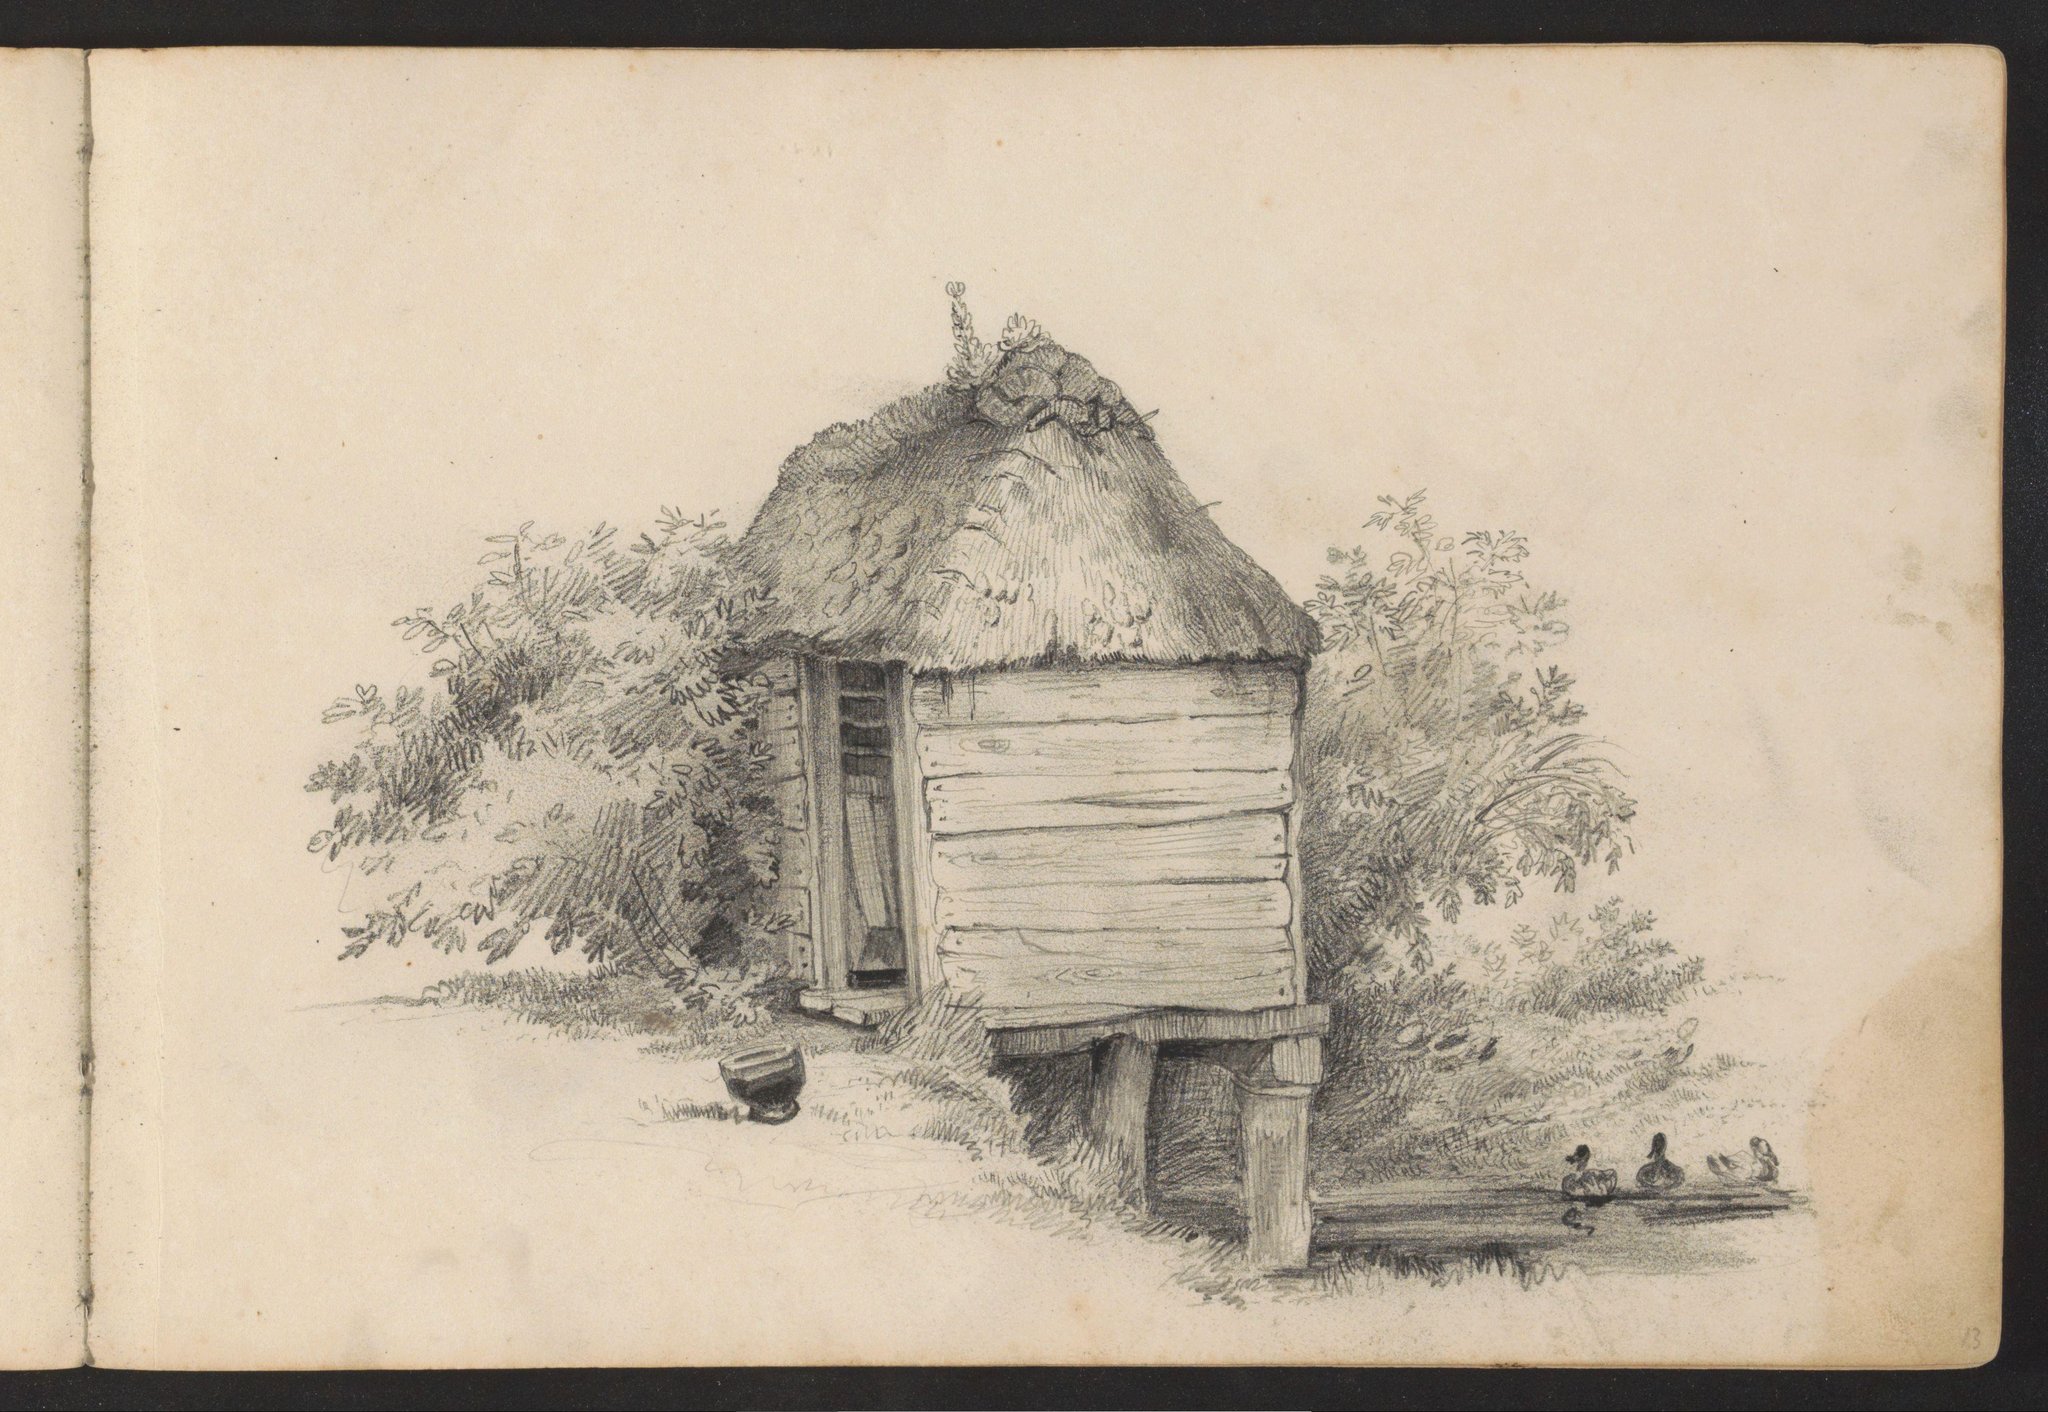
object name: sketchbook leaf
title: Hut op palen aan de waterkant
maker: johannes tavenraat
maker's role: draughtsman, painter, print maker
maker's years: 1809-1881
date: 1842-1868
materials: paper, pencil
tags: river, hut, cabin, lodge, water-birds: duck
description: De hut is van hout en heeft een rieten dak. In het water zwemmen eenden. Blad 13 recto uit een schetsboek met 45 bladen.